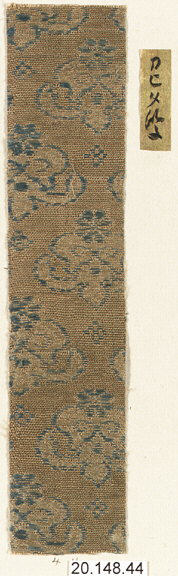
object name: piece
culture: japanese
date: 1401-1500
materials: silk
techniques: compound weave